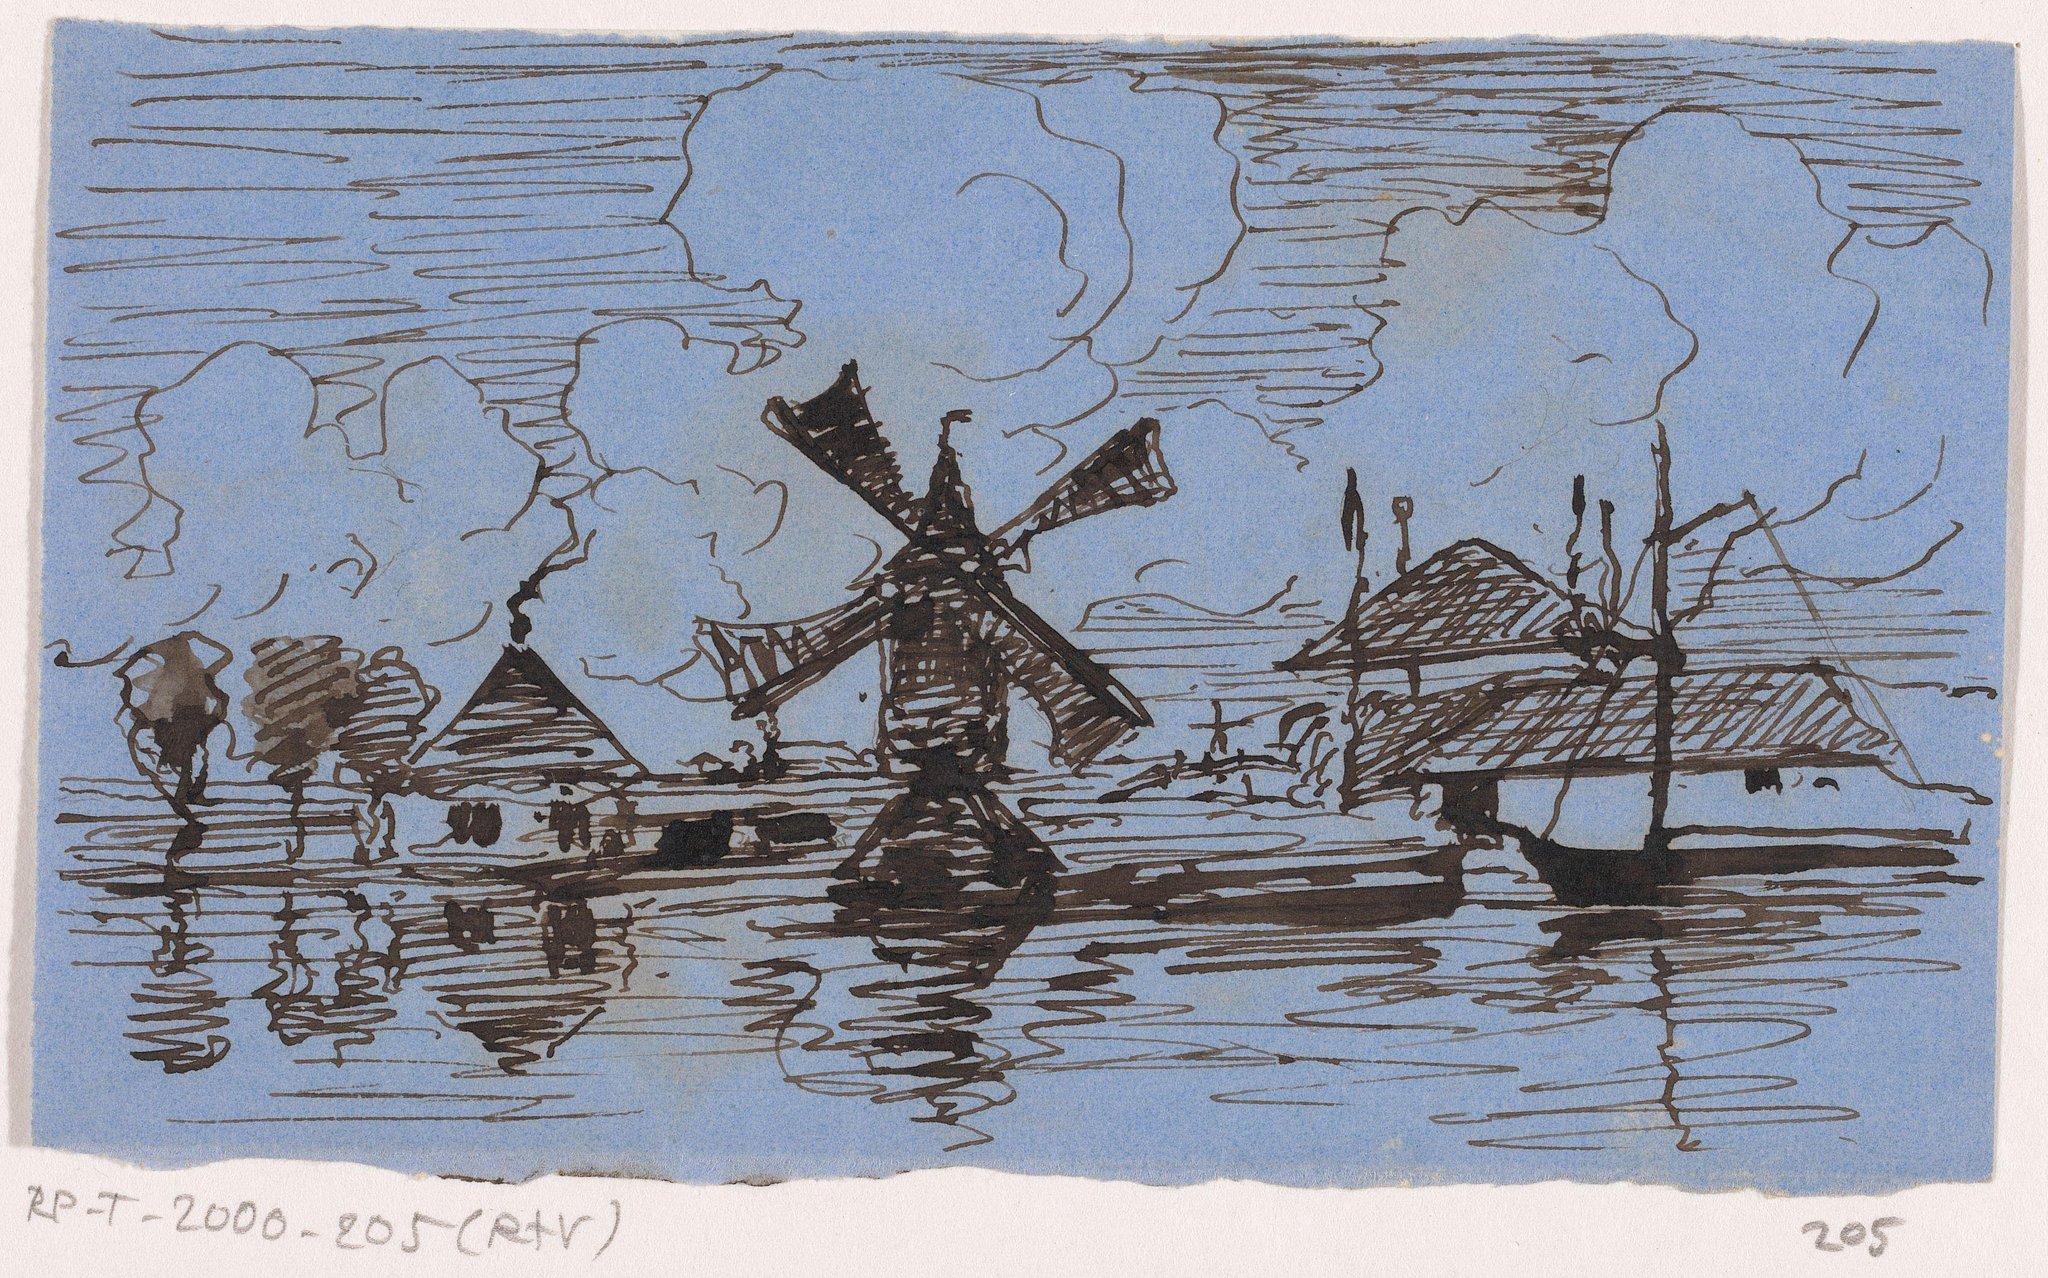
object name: drawing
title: Rivierlandschap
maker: johannes tavenraat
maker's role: draughtsman, painter, print maker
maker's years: 1809-1881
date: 1840-1880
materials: ink, paper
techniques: pen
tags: windmill in landscape, river (+ landscape with figures, staffage)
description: Rivierlandschap met molen en boerderij met hooischuur.